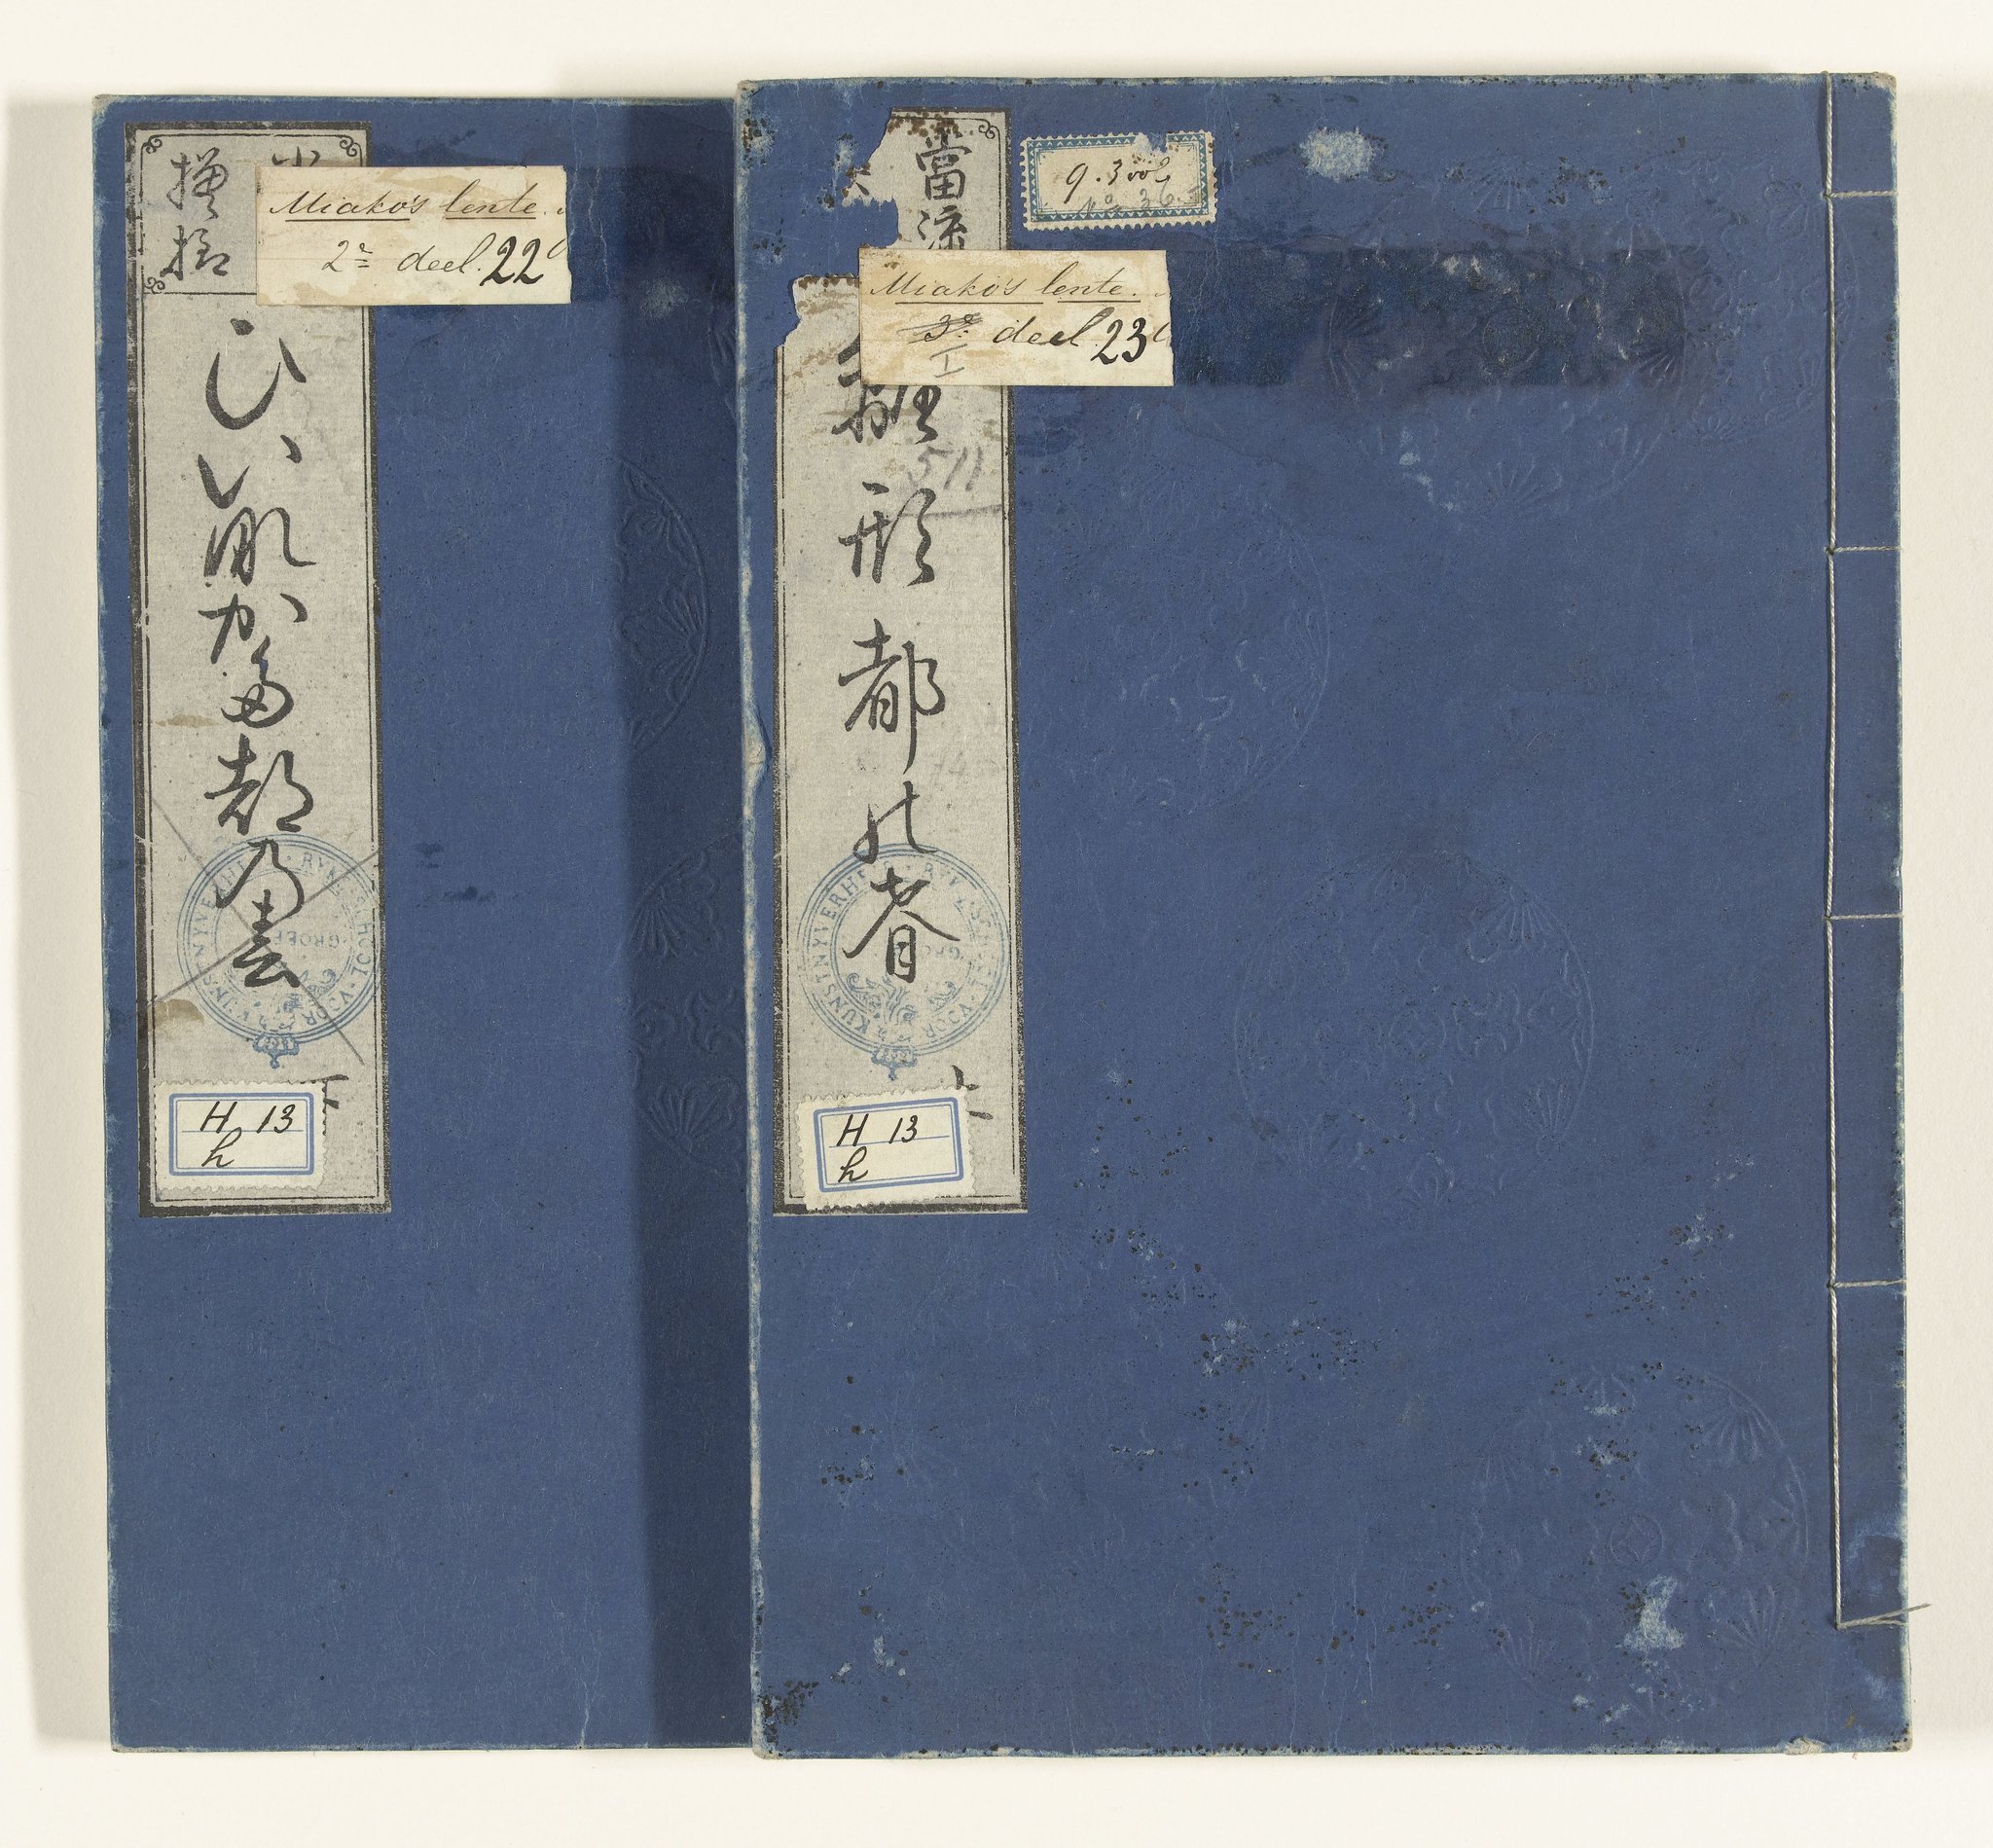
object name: book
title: Lentepatronen voor de hoofdstad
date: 1885-1890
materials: paper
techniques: woodcut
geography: osaka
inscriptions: collector's mark: ‘Rijksschool voor kunstnijverheid’ Lugt 3937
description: Aangezien de nummering van de ontwerpen in het eerste deel begint met nummer 51, lijken deze drie lente delen onderdeel uit te maken van een grotere reeks kimonopatronen.